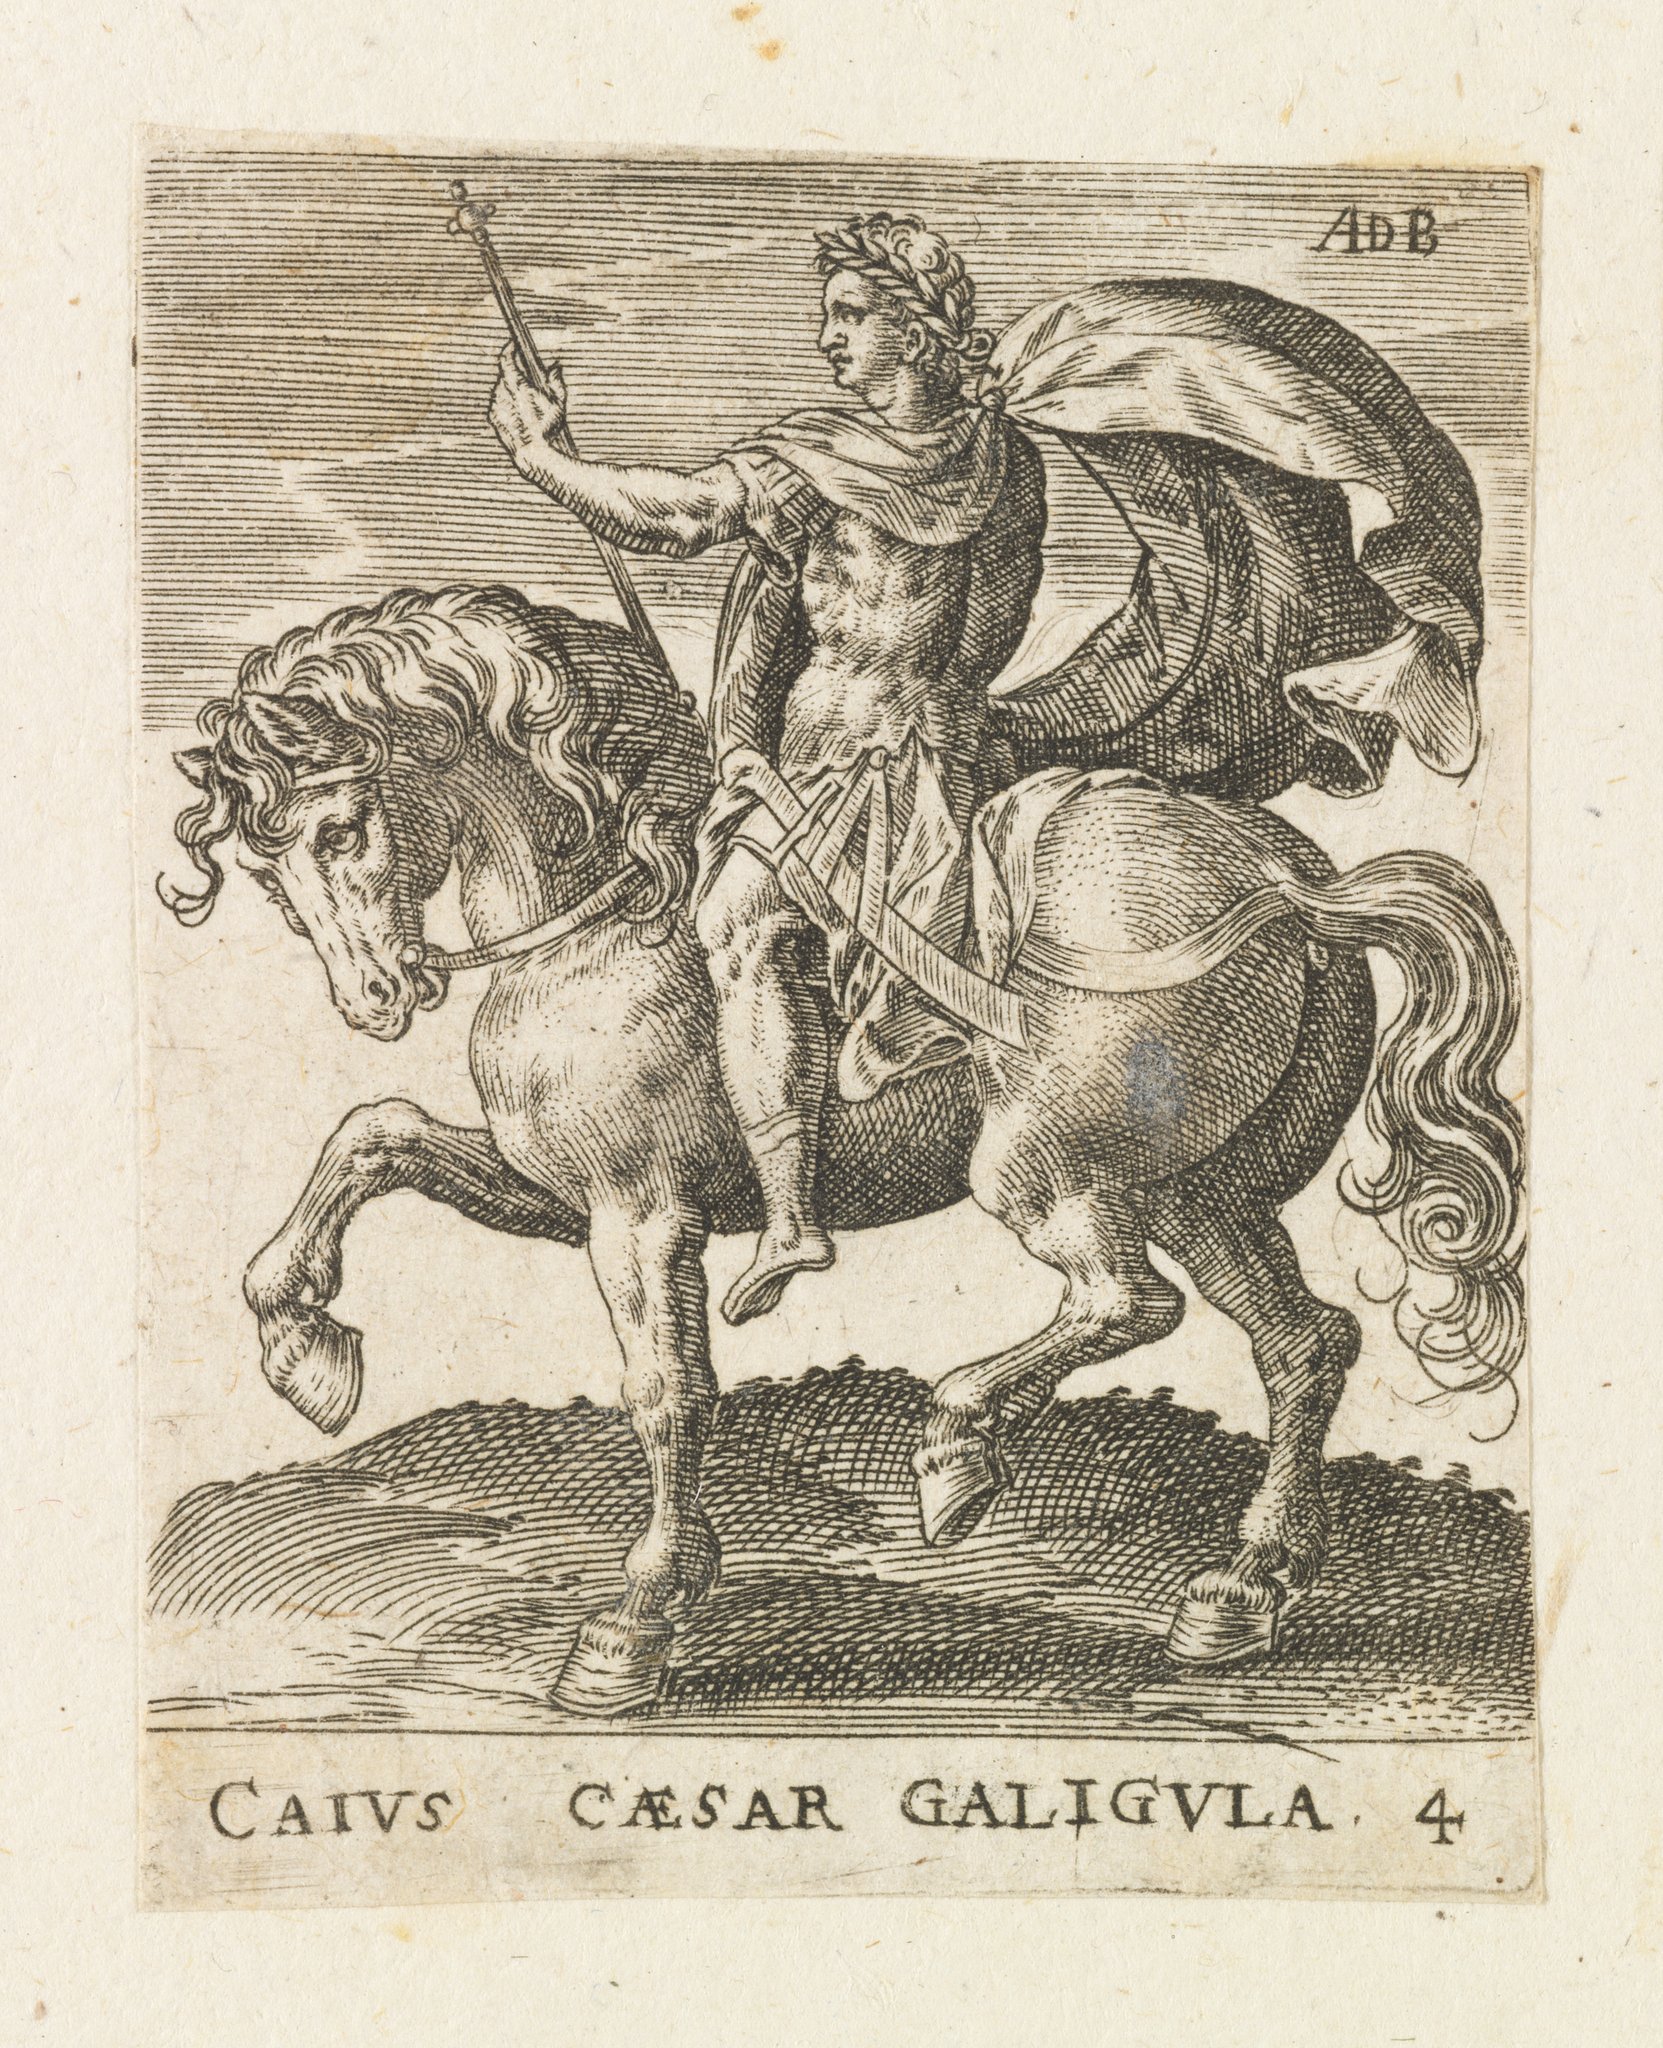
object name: print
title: Caius Caesar Galigula, from "Twelve Caesars on Horseback"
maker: abraham de bruyn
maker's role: artist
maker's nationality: flemish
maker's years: 1540-1587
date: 1565-1587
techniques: engraving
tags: men,horses